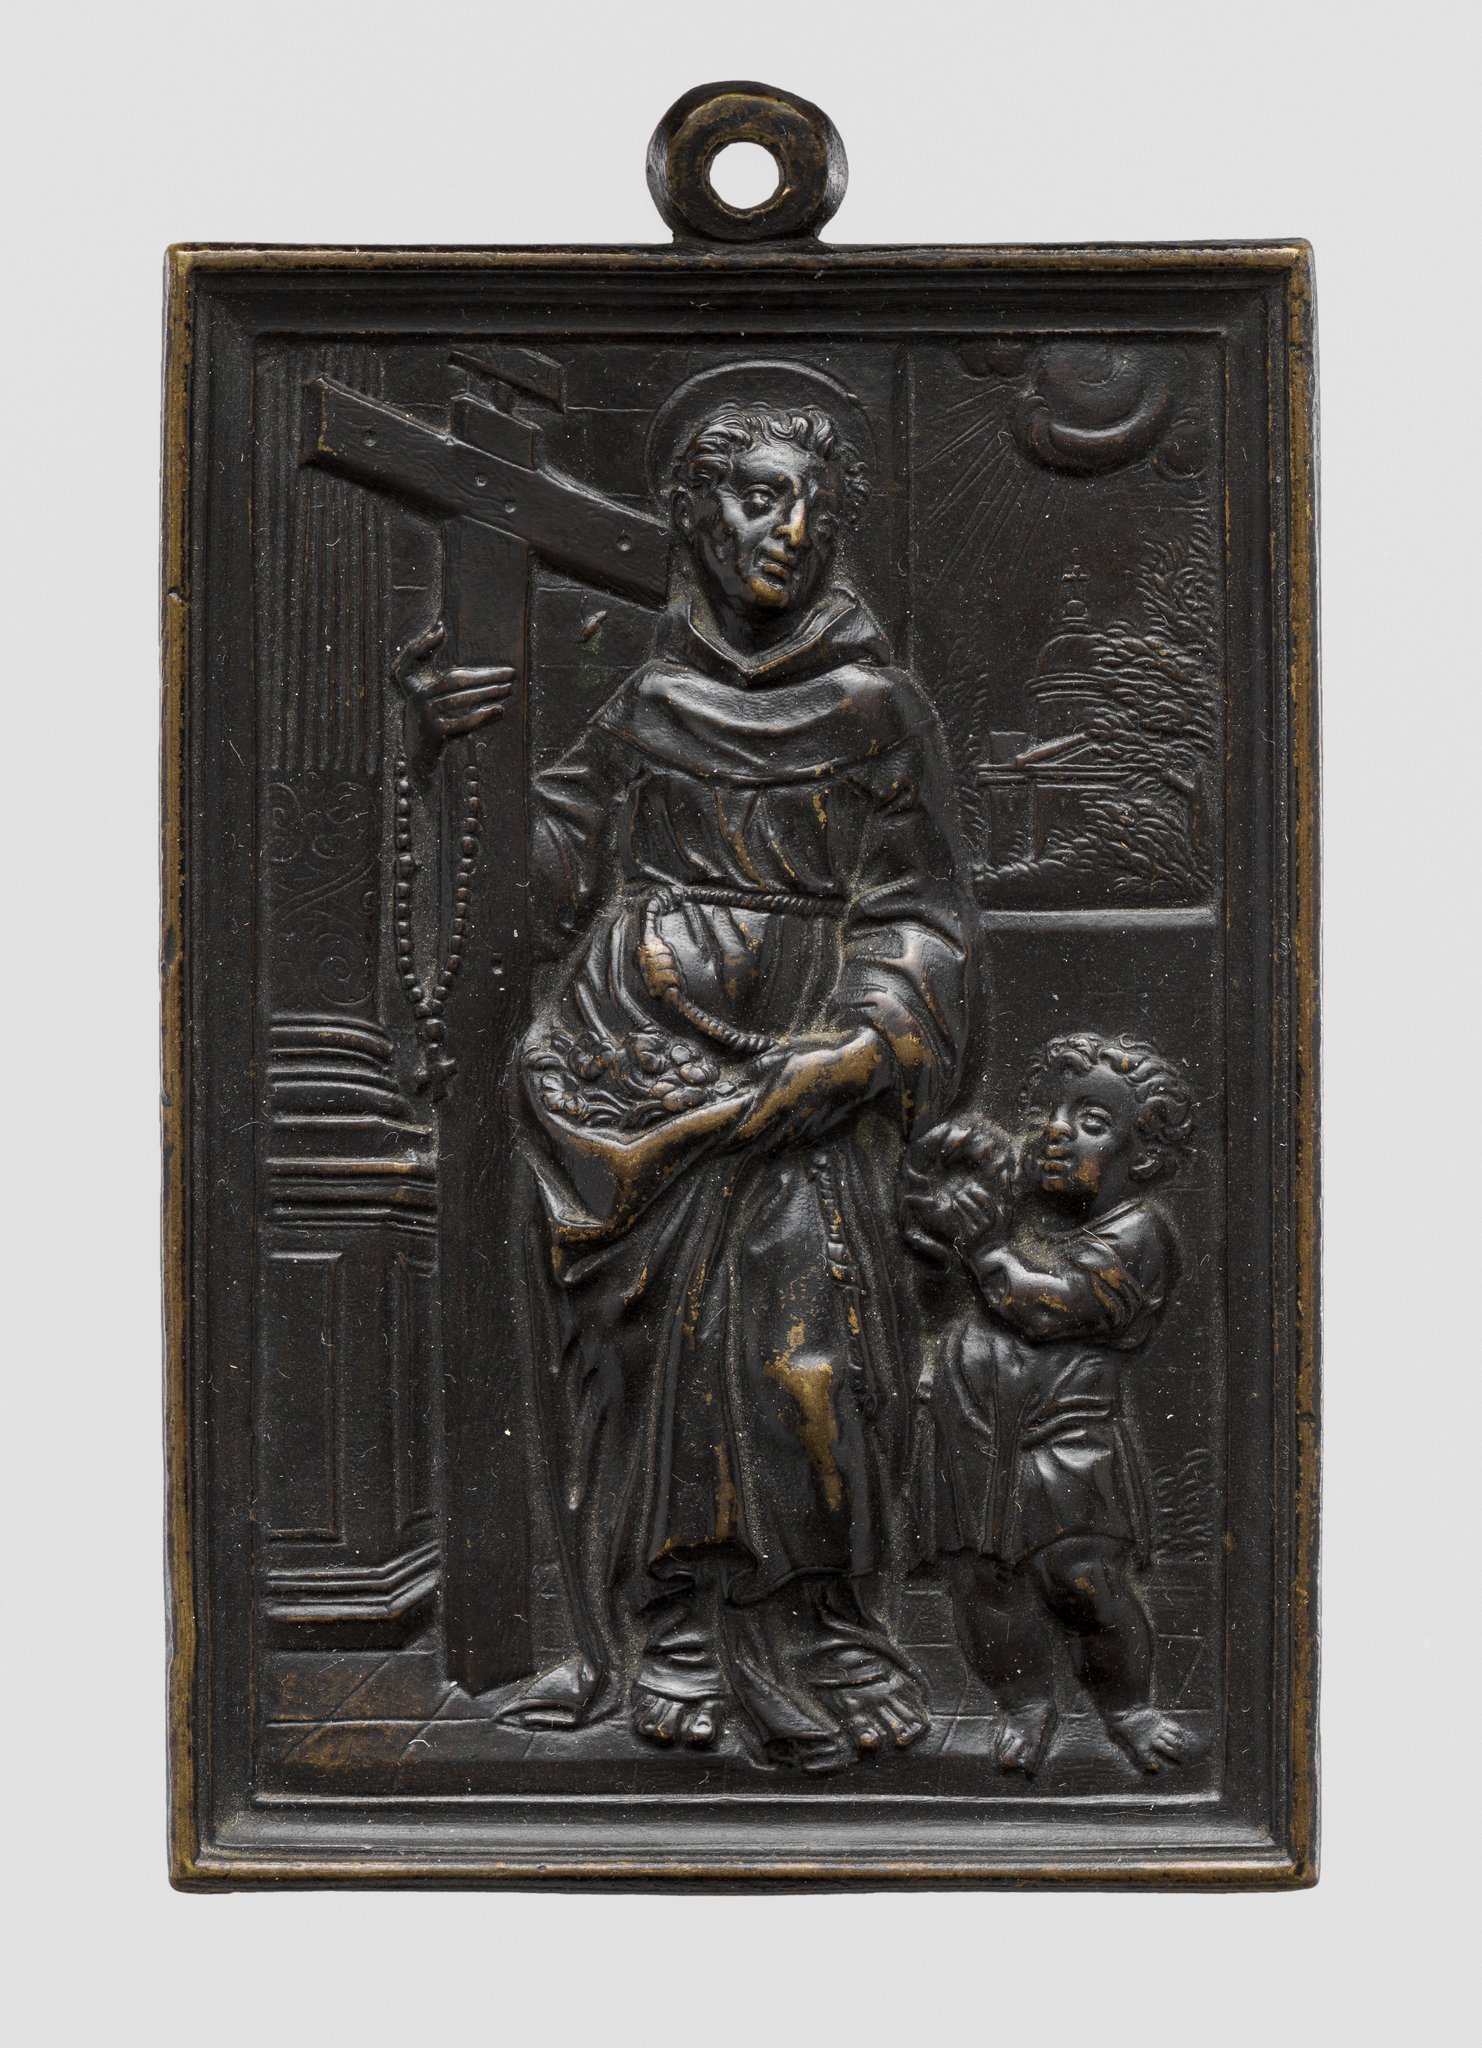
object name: plaquette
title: Saint Didacus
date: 1601-1633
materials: bronze, patina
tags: children,cross,rosaries,saints